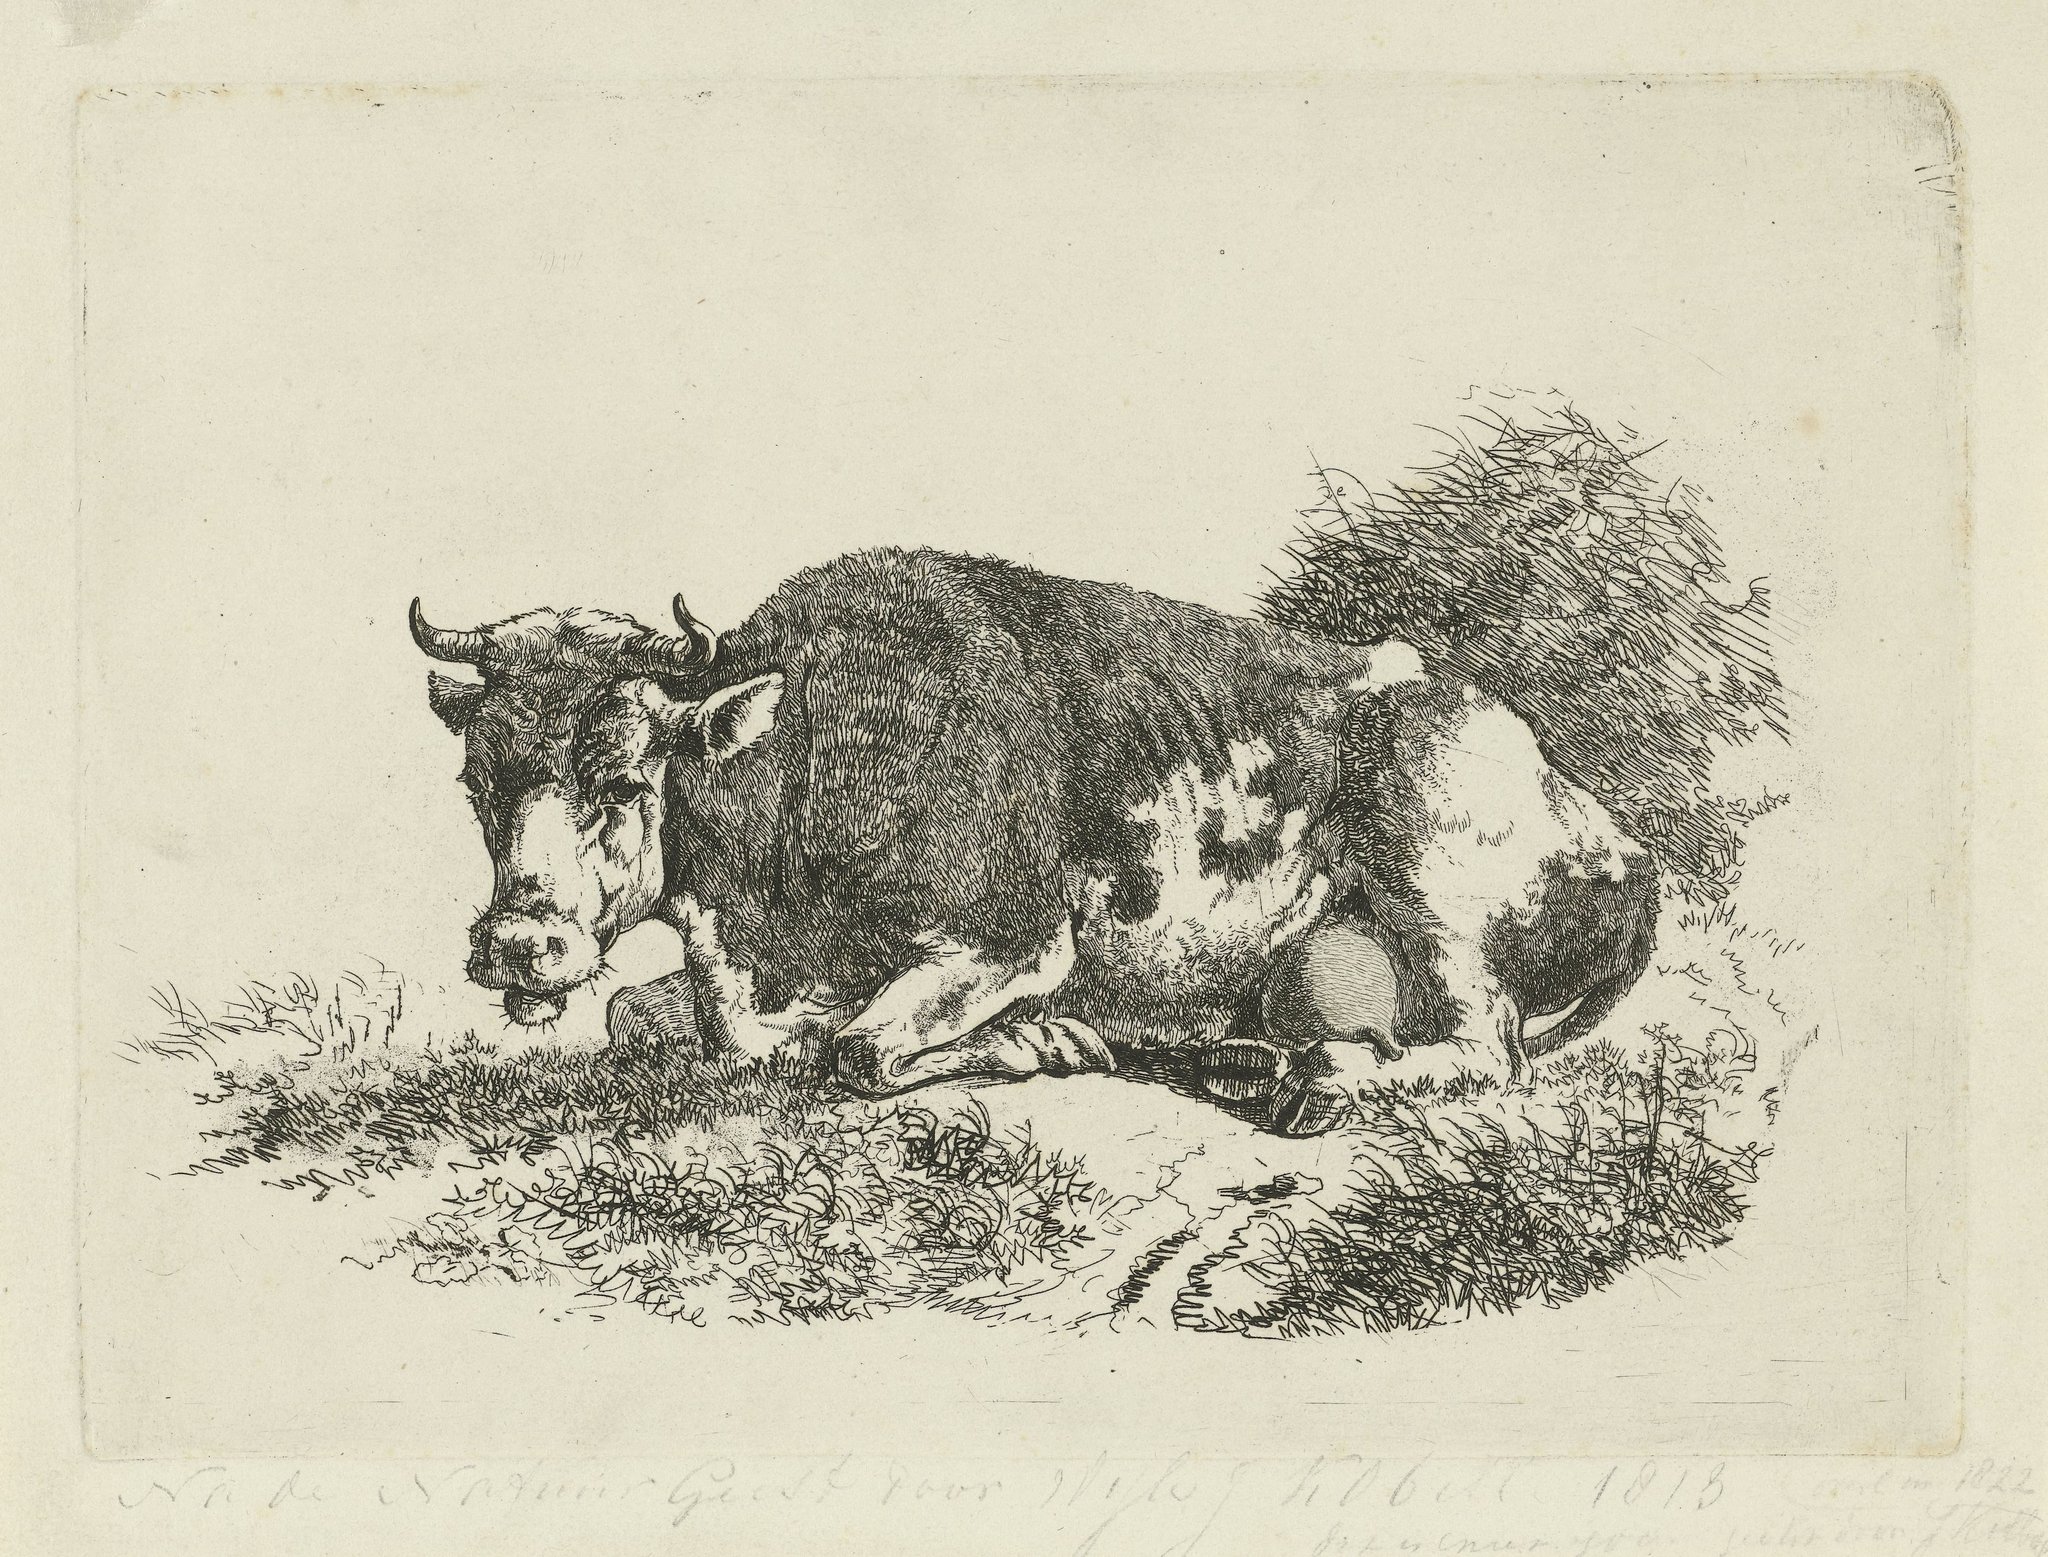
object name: print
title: Liggende koe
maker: jan kobell (iii)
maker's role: painter, print maker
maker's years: 1800-1838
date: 1810-1838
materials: paper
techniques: etching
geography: rotterdam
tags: cow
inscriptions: collector's mark: Lugt 2228, inscription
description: Liggende koe, naar links, in een landschap. Op de achterzijde van de prent staan twee getekende medaillons.